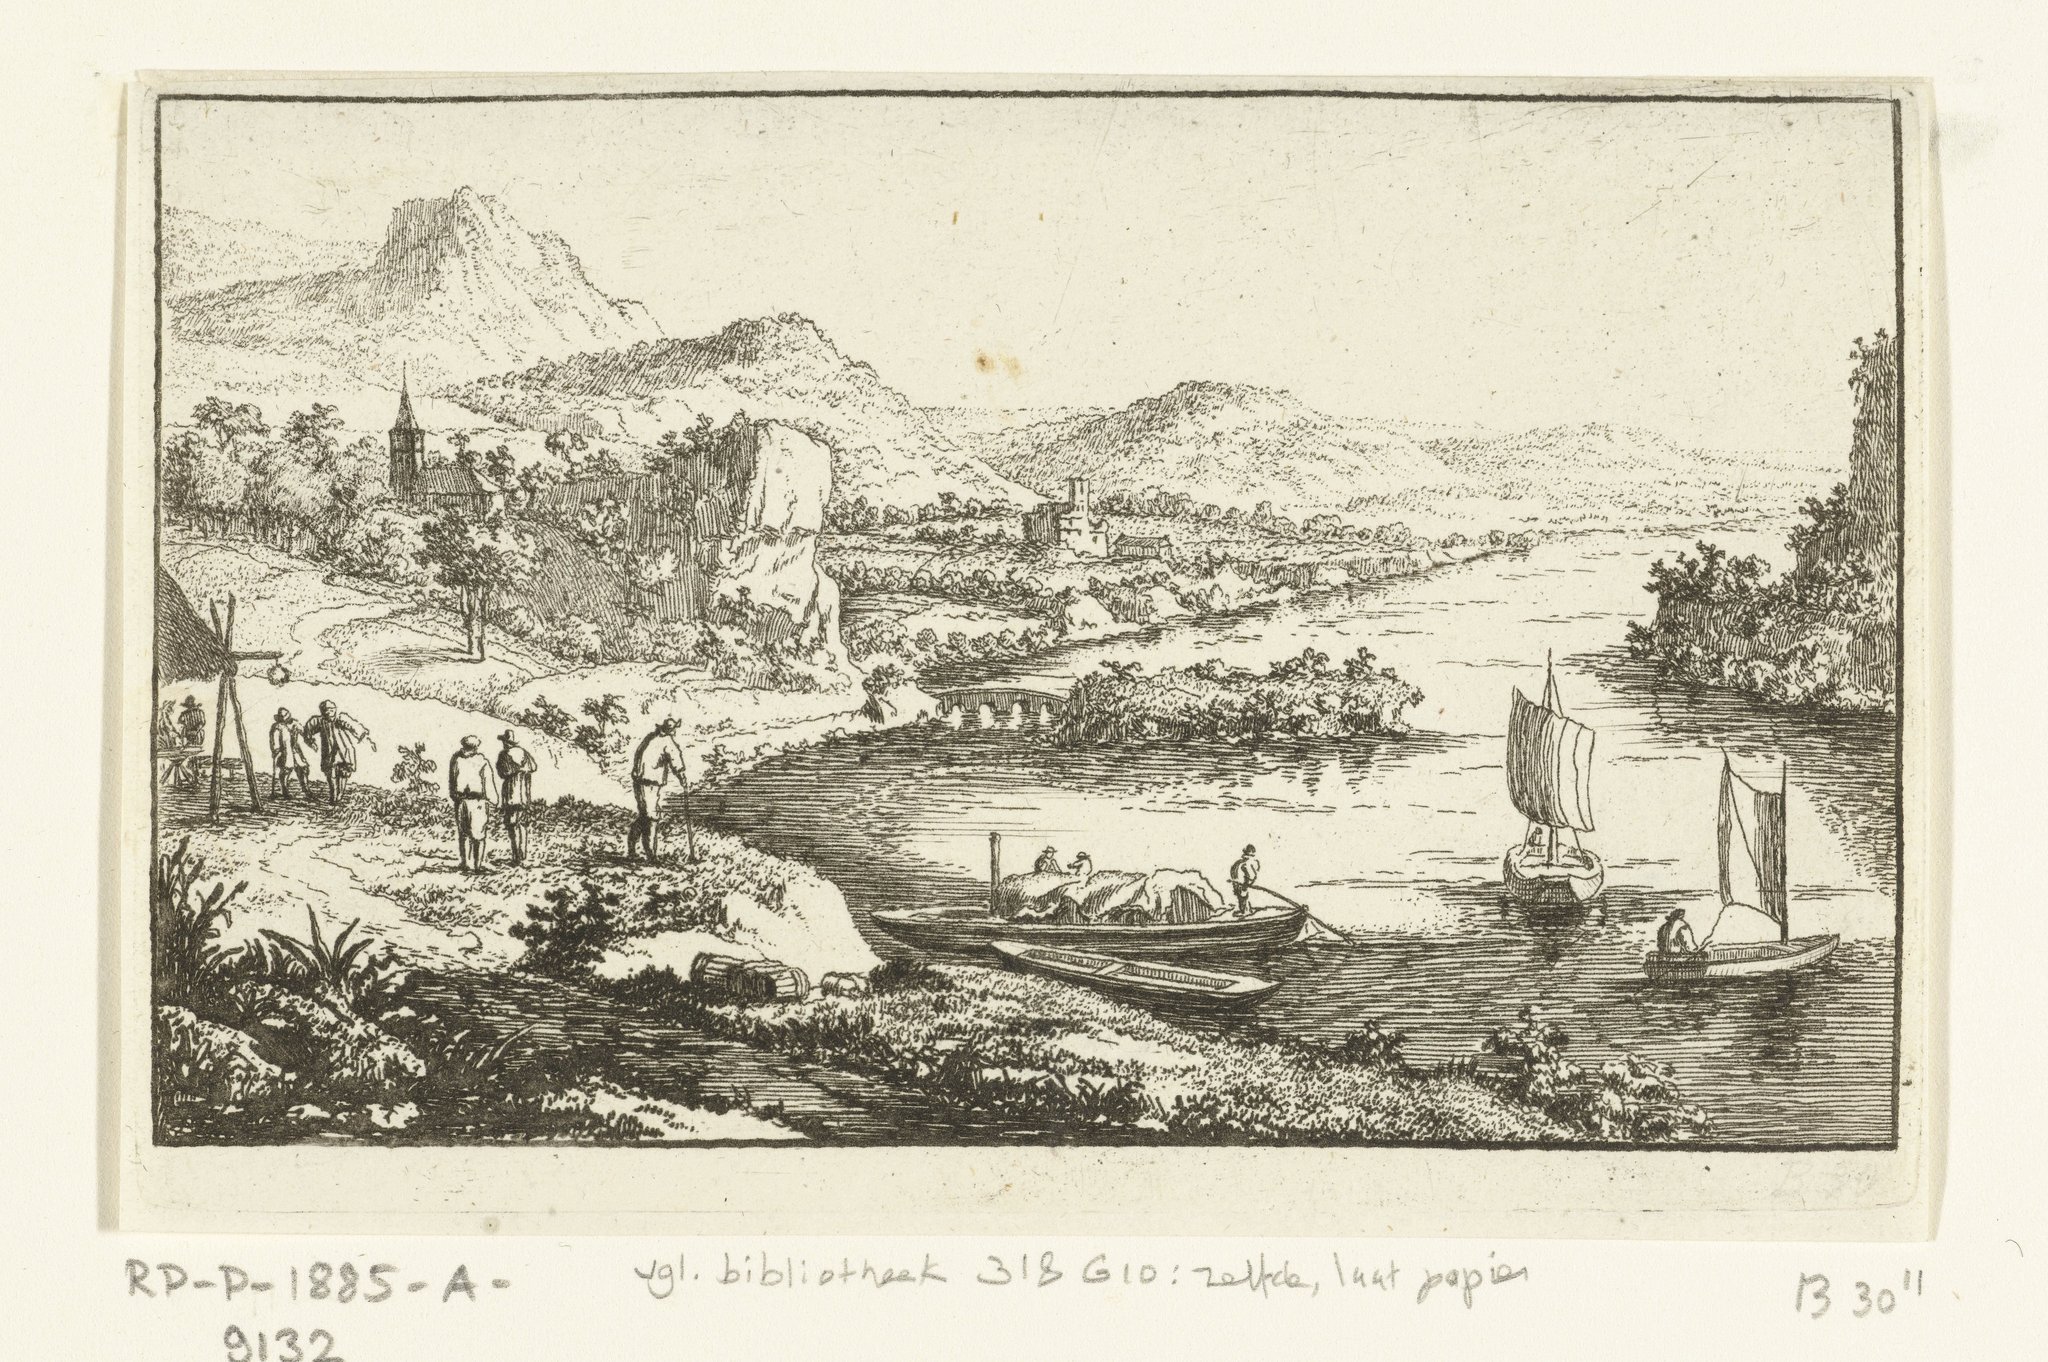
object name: print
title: Zes landschappen, tweede serie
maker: jan van almeloveen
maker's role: draughtsman, print maker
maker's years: 1652-1683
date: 1662-1683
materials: paper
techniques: etching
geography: netherlands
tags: island, river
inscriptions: collector's mark: Lugt 2228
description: Als boekillustratie gebruikt in: Spiegel der natuur en school der teekenkunde, Amsterdam, J.S. van Esveldt-Holtrop, c. 1780 (RMAB 318 G 10)